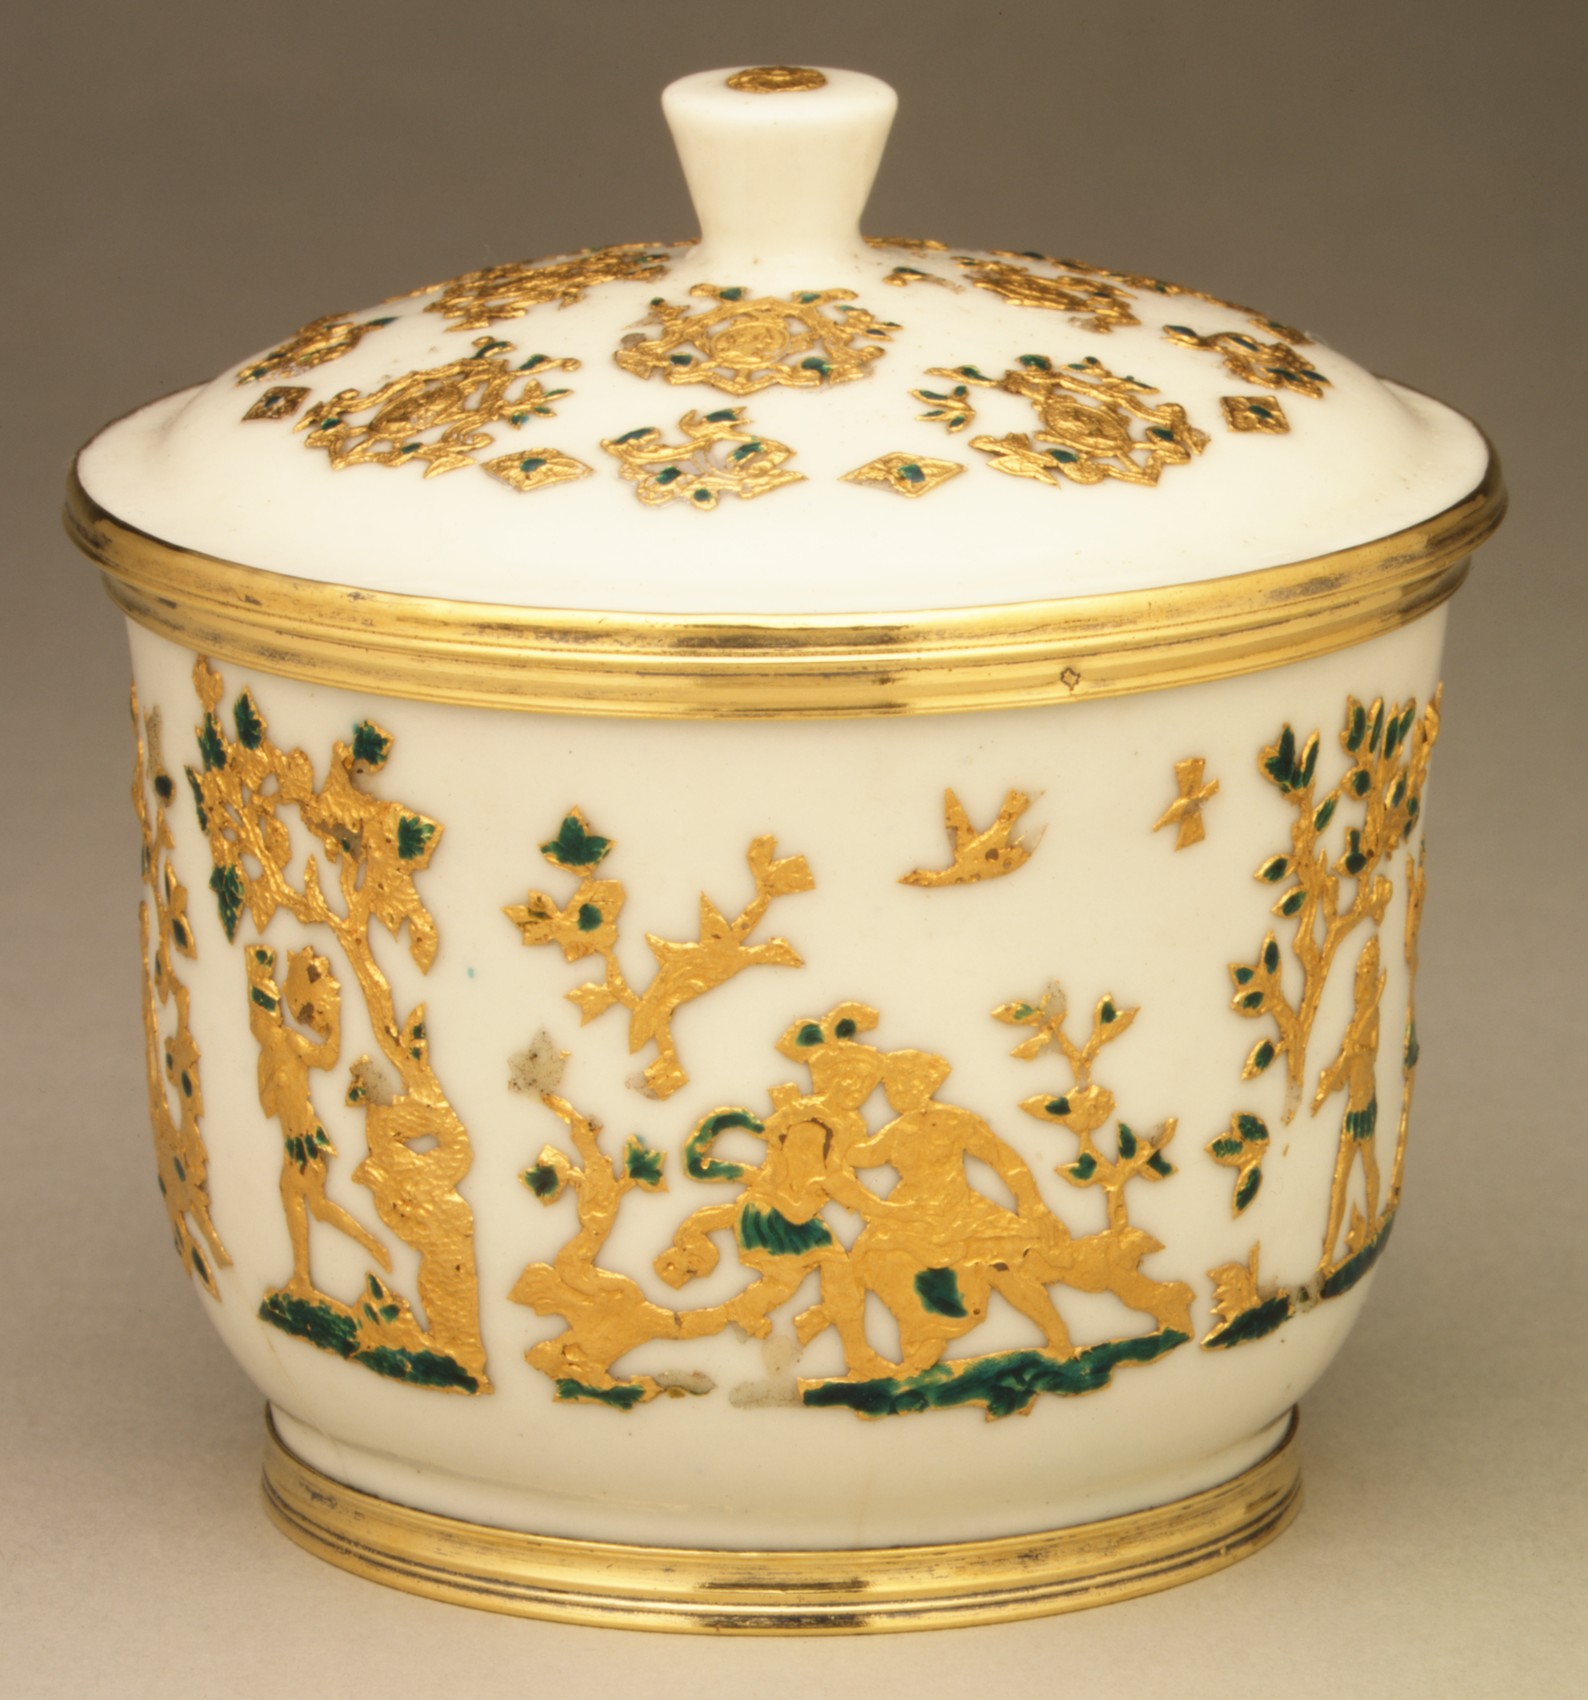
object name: jar with cover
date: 1725-1730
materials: silver gilt, soft paste porcelain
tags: human figures,birds